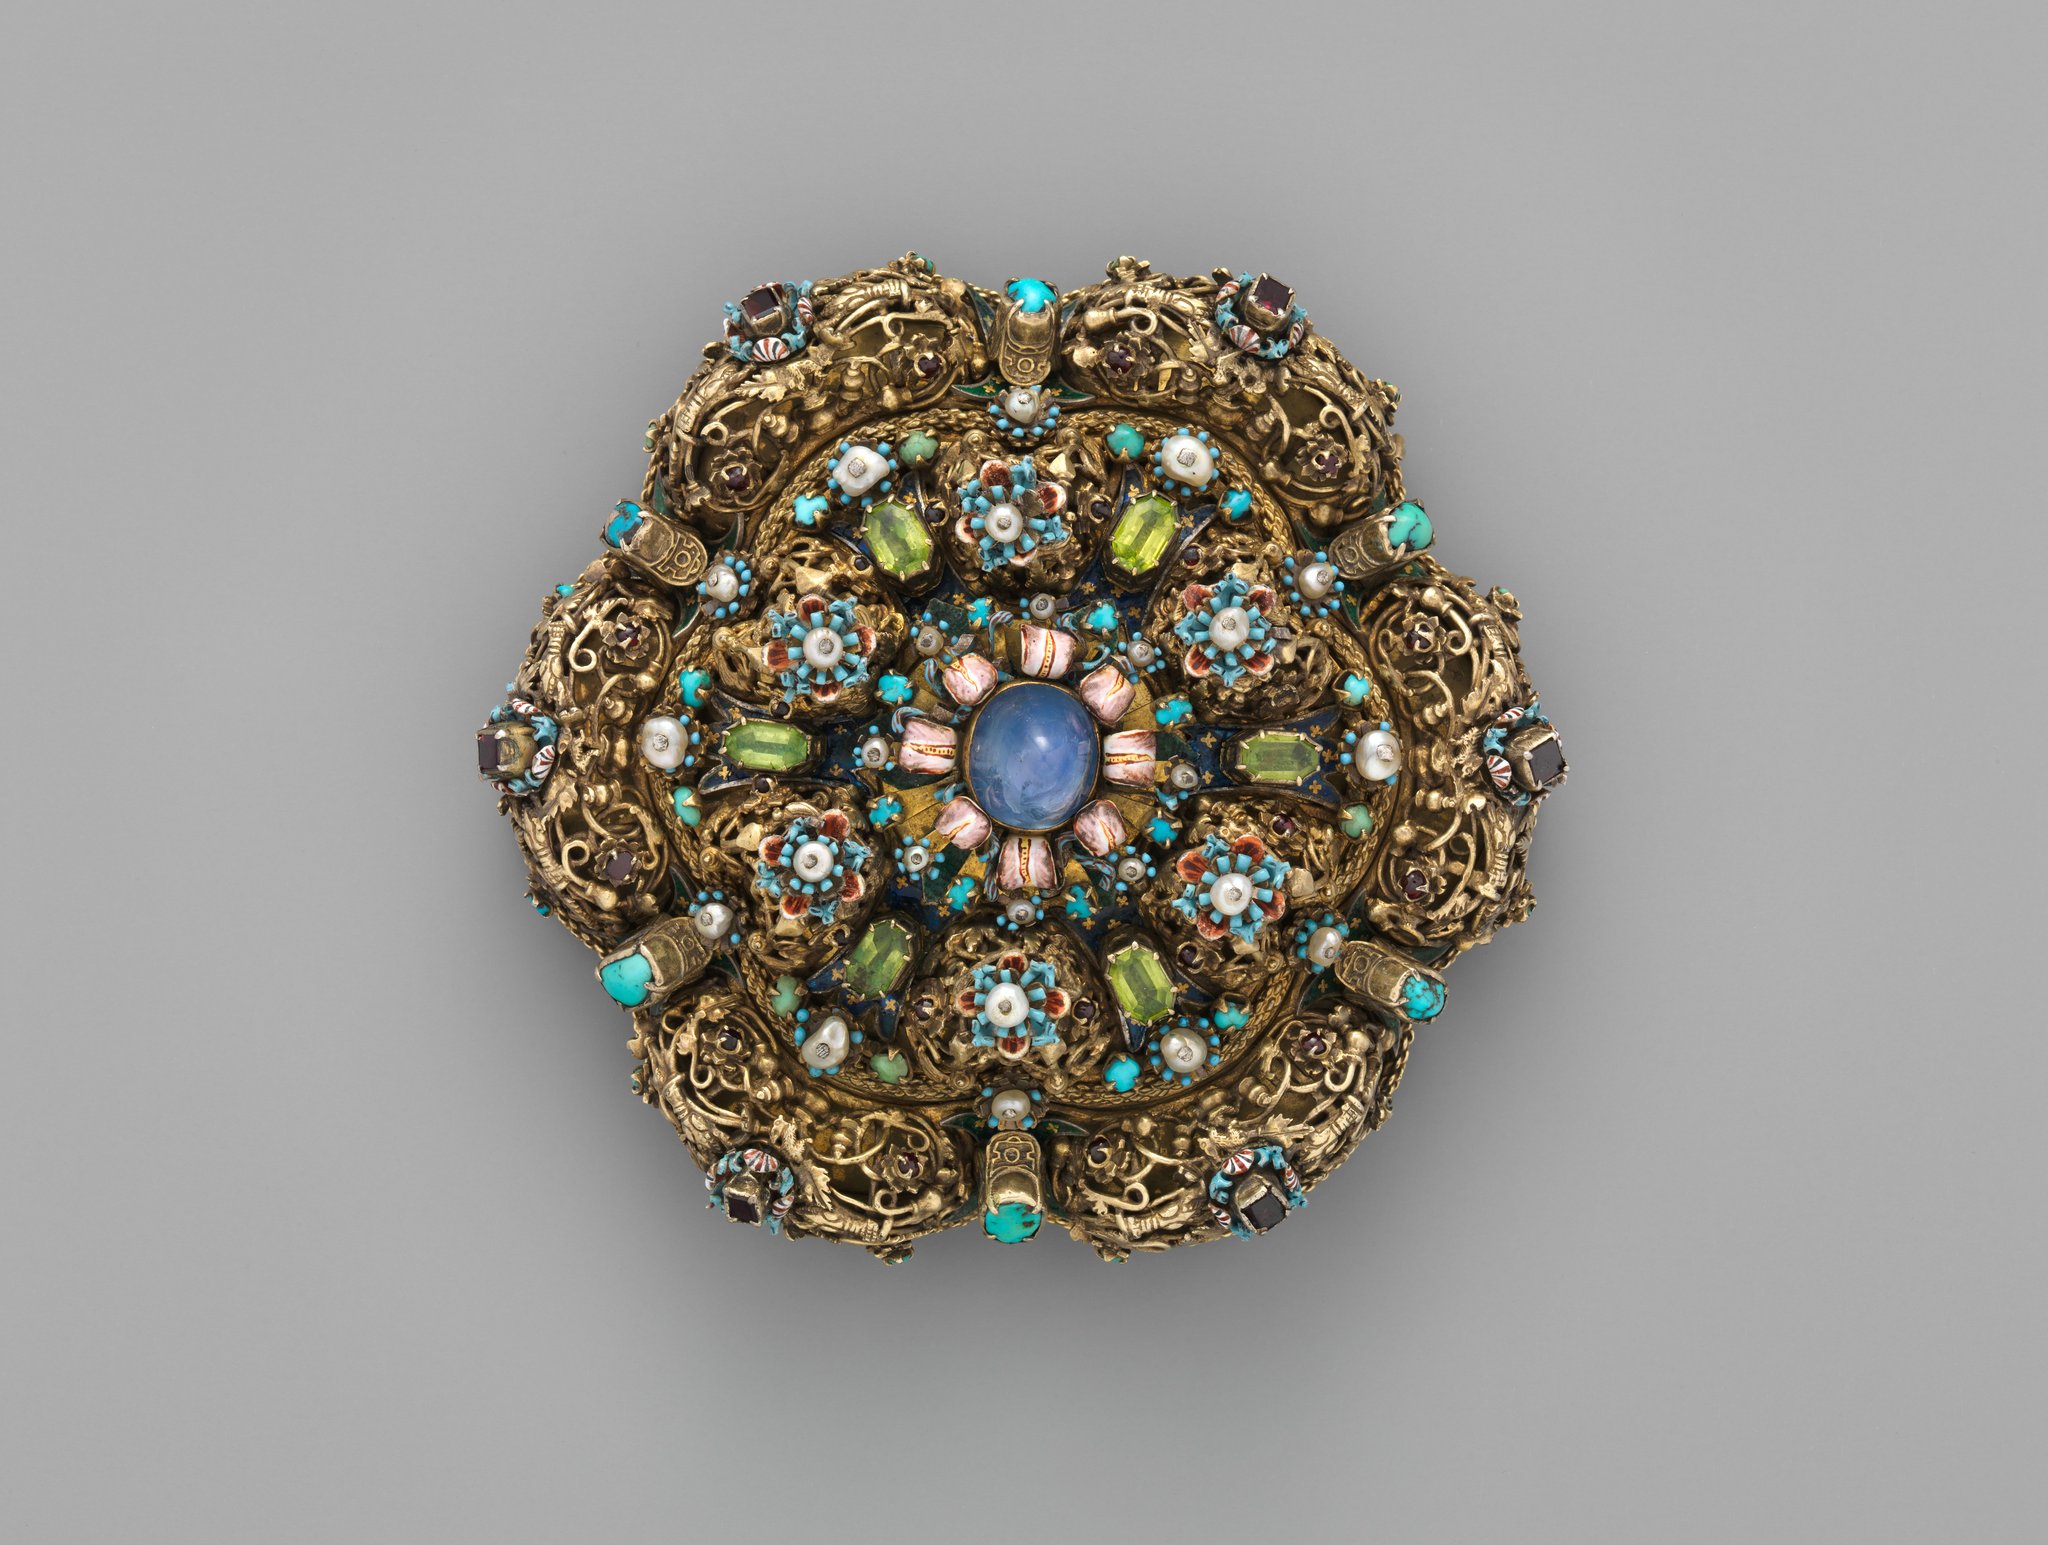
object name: ornament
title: Dress ornament (heftel)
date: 1701-1800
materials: enamel, gold, gemstone, stone